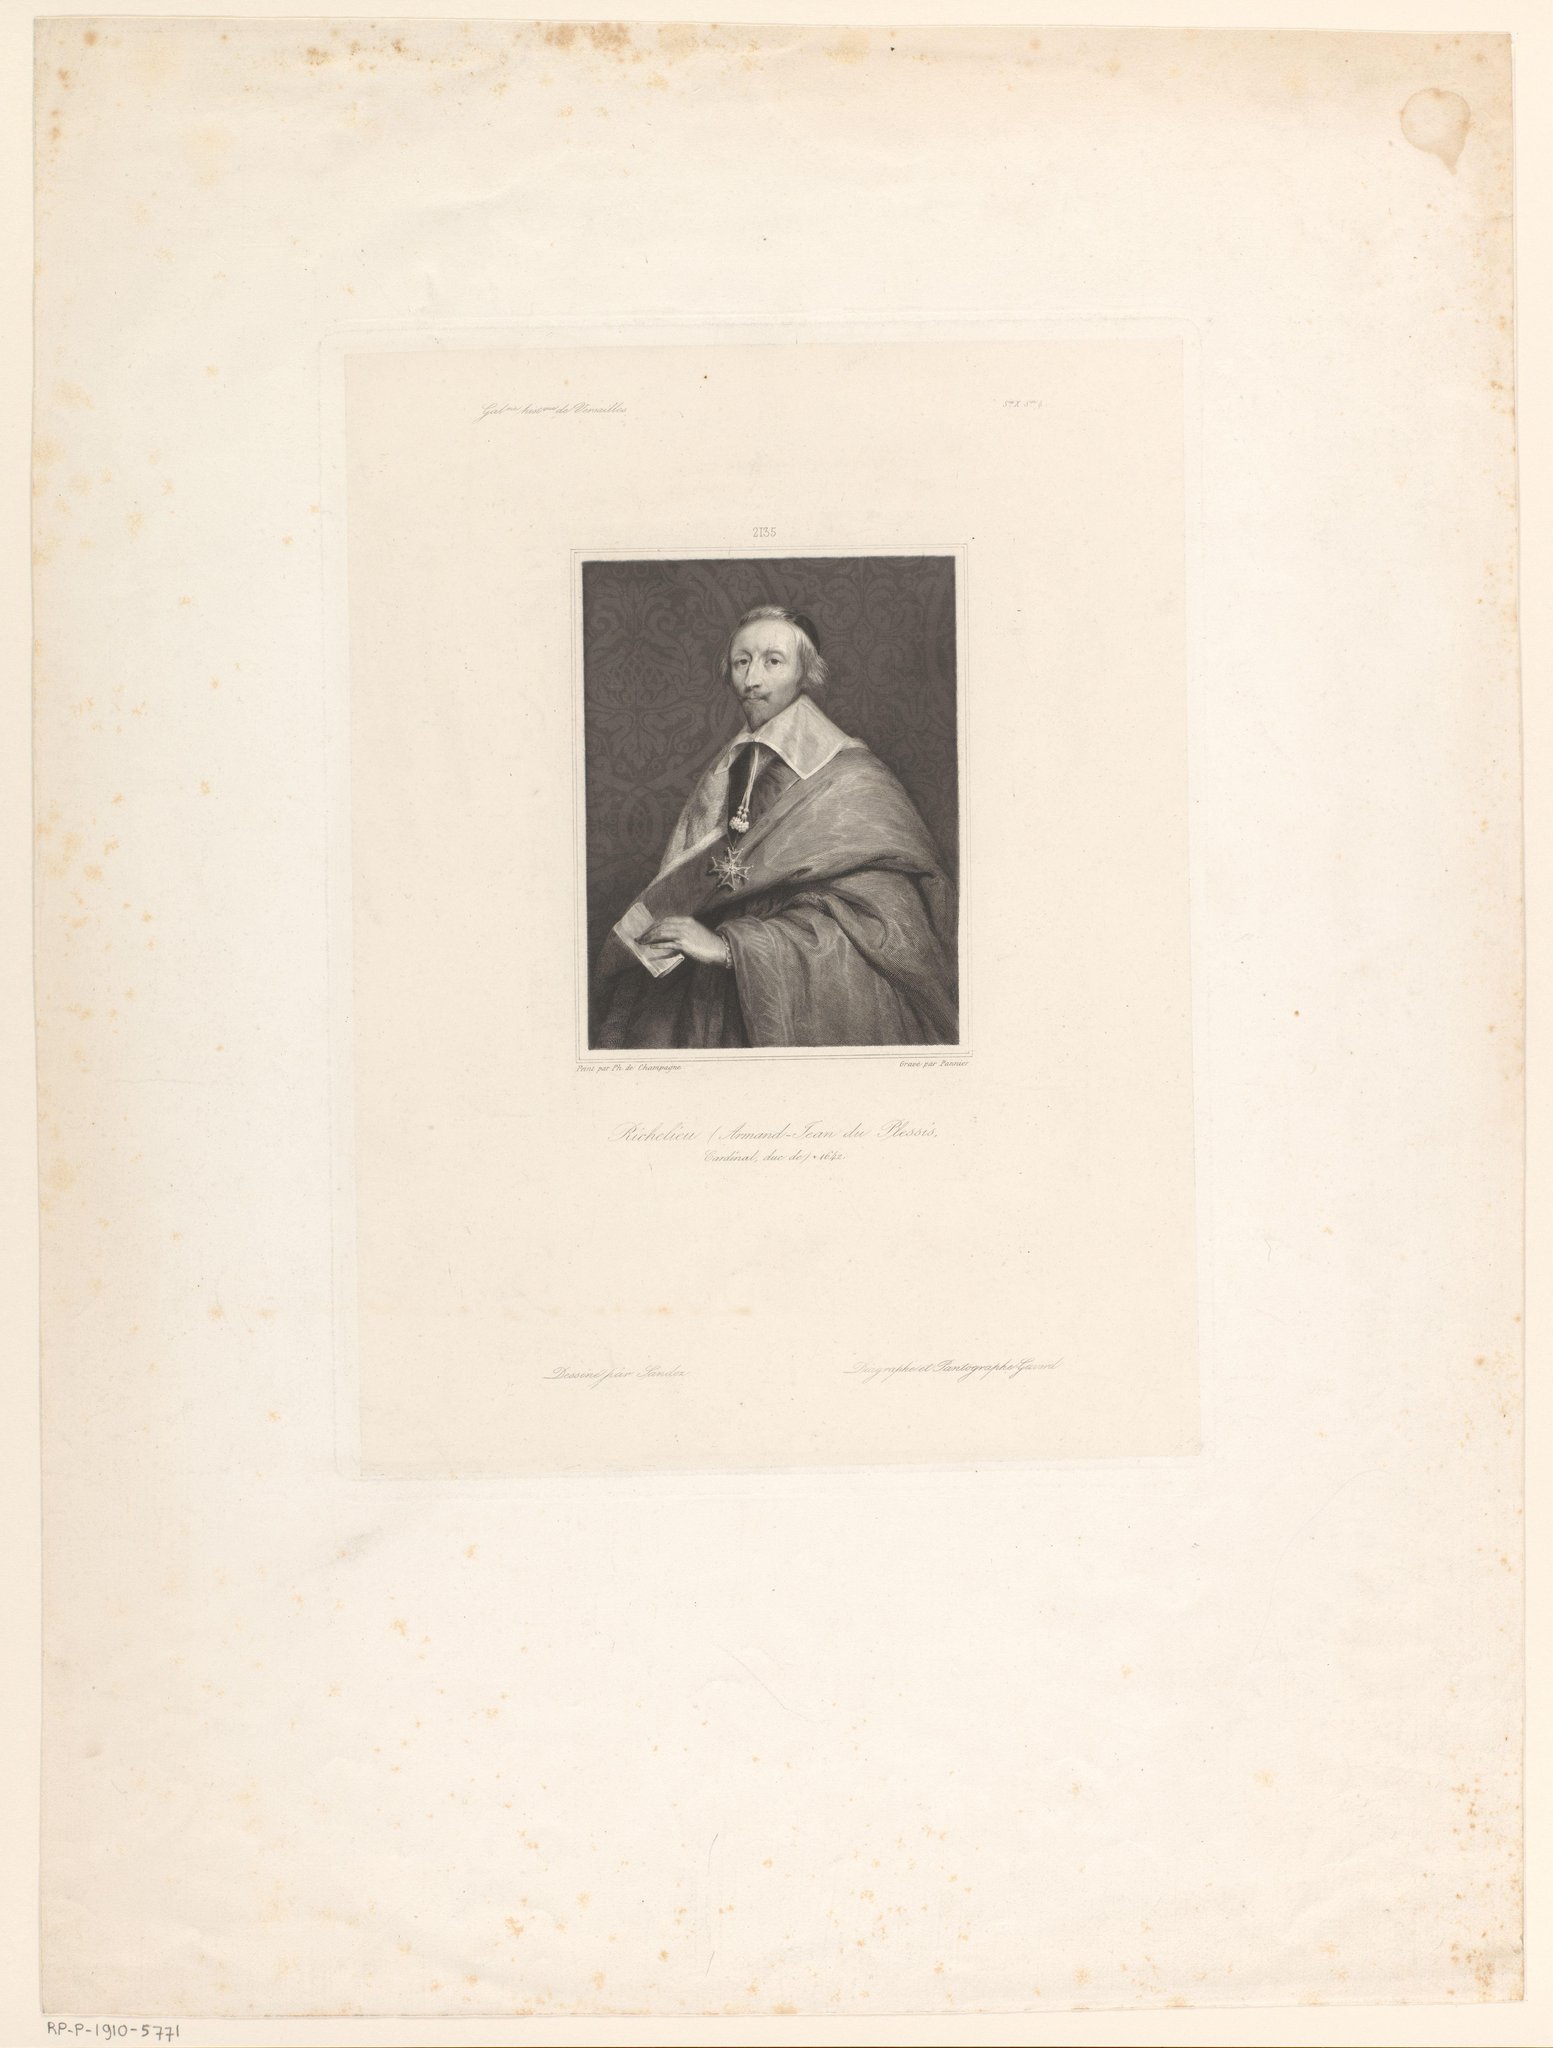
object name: print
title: Richelieu (Armand-Jean du Plessis, Cardinal, duc de)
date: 1812-1869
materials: paper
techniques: engraving, etching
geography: paris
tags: paris, armand-jean du plessis hertog van richelieu, cardinal, historical persons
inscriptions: collector's mark: Lugt 2228